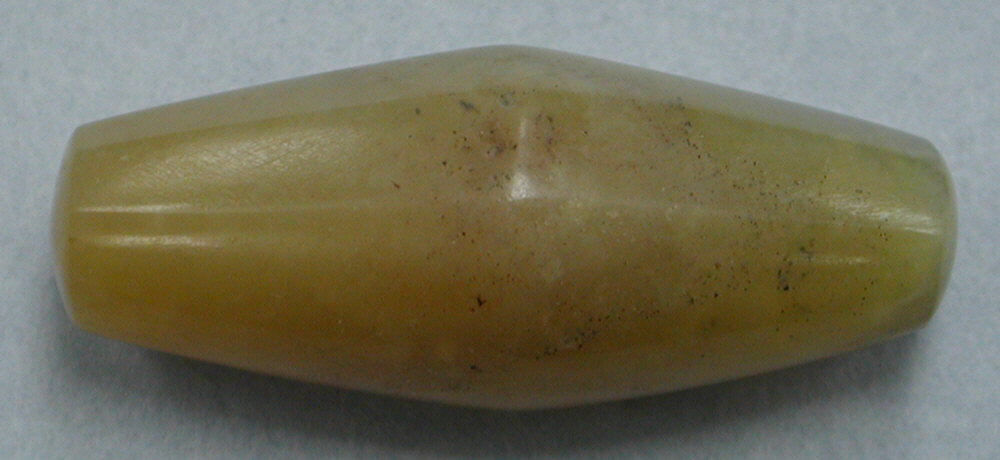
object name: ritual stone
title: Polishing Stone (pulidor)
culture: mexican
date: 1501-1600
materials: stone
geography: mexico